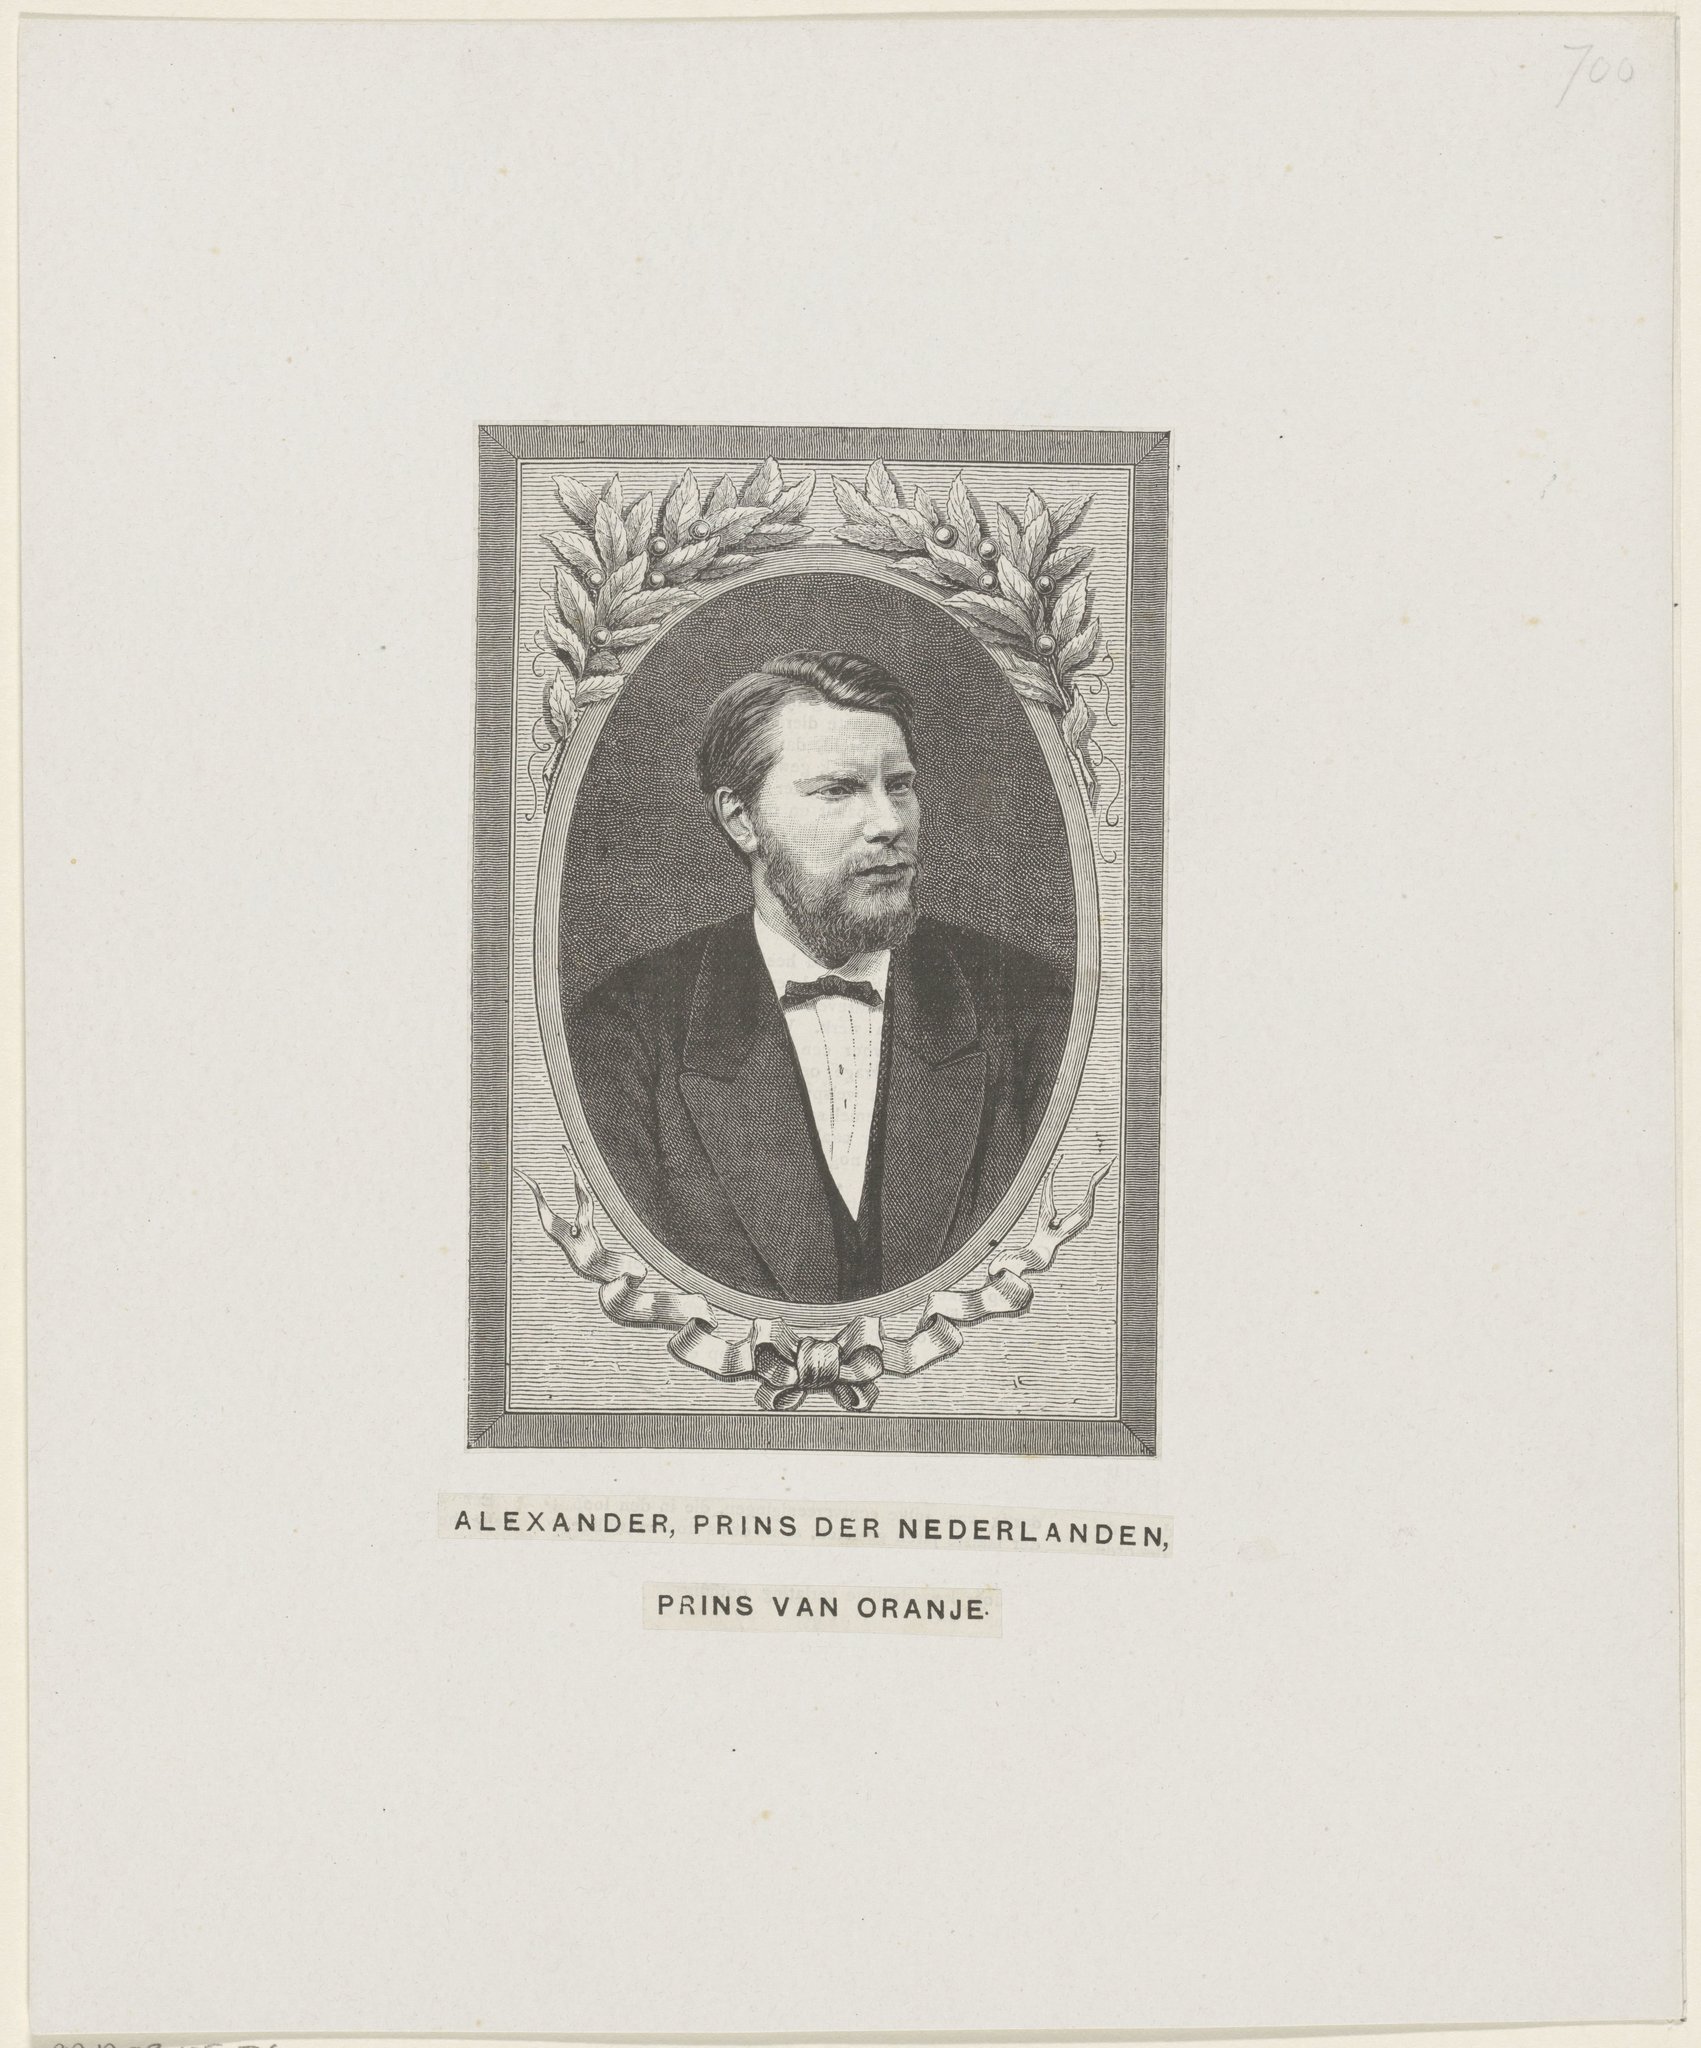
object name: print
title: Portret van Alexander, prins der Nederlanden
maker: Anonymous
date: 1870-1949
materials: paper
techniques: engraving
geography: netherlands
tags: prins, alexander (prins der nederlanden)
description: De hier vermelde titel verwijst naar de hoogst verkregen titel van de geportretteerde, niet per se naar de titel die de geportretteerde op deze voorstelling draagt.